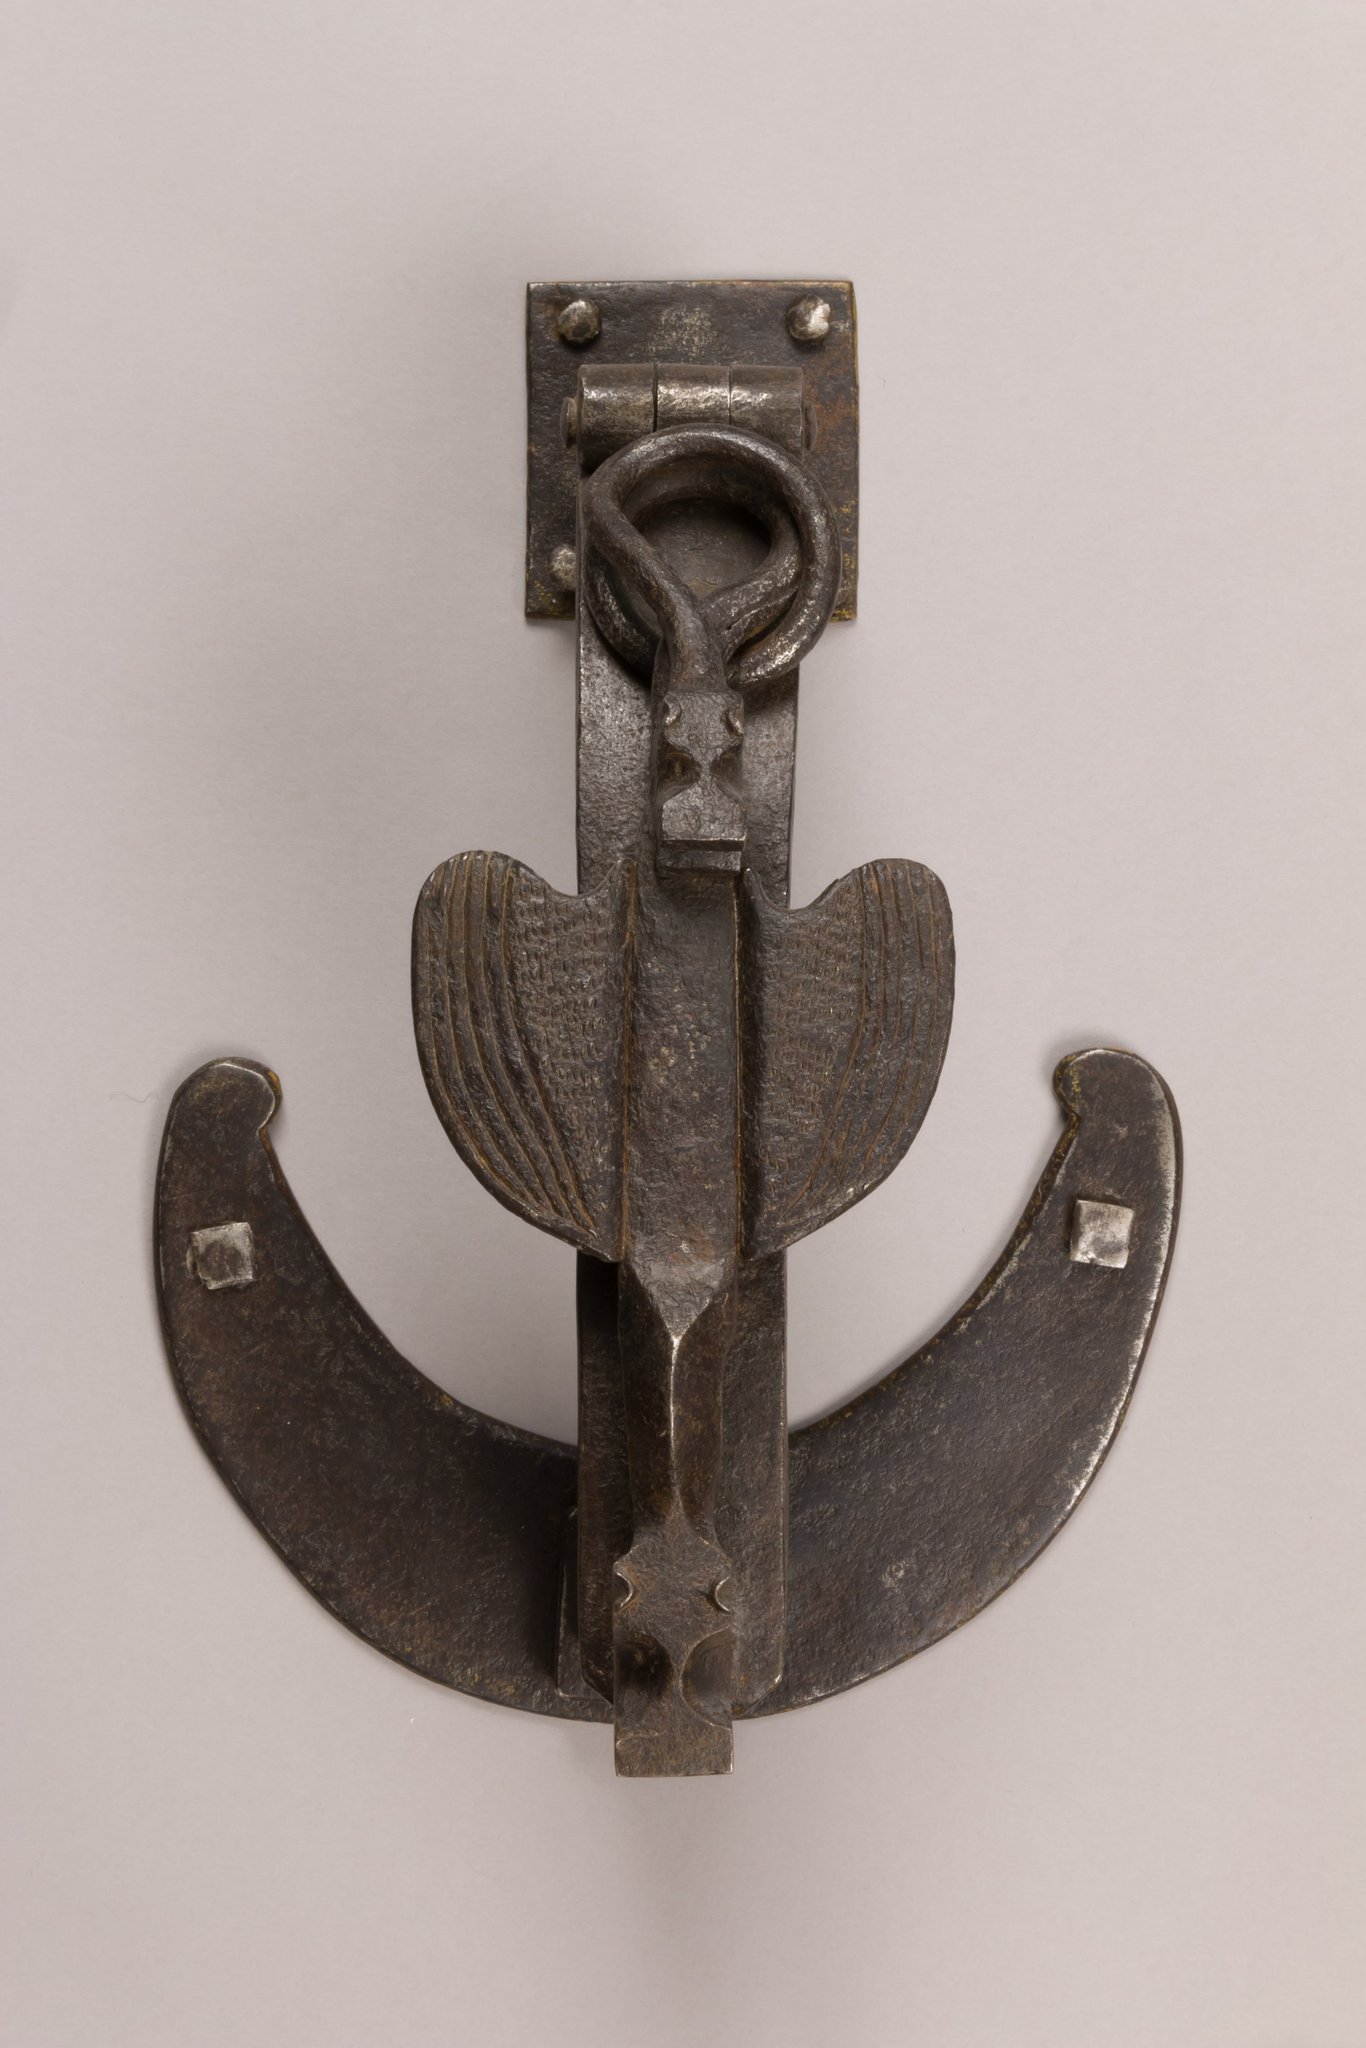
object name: door knocker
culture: spanish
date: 1401-1500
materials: iron